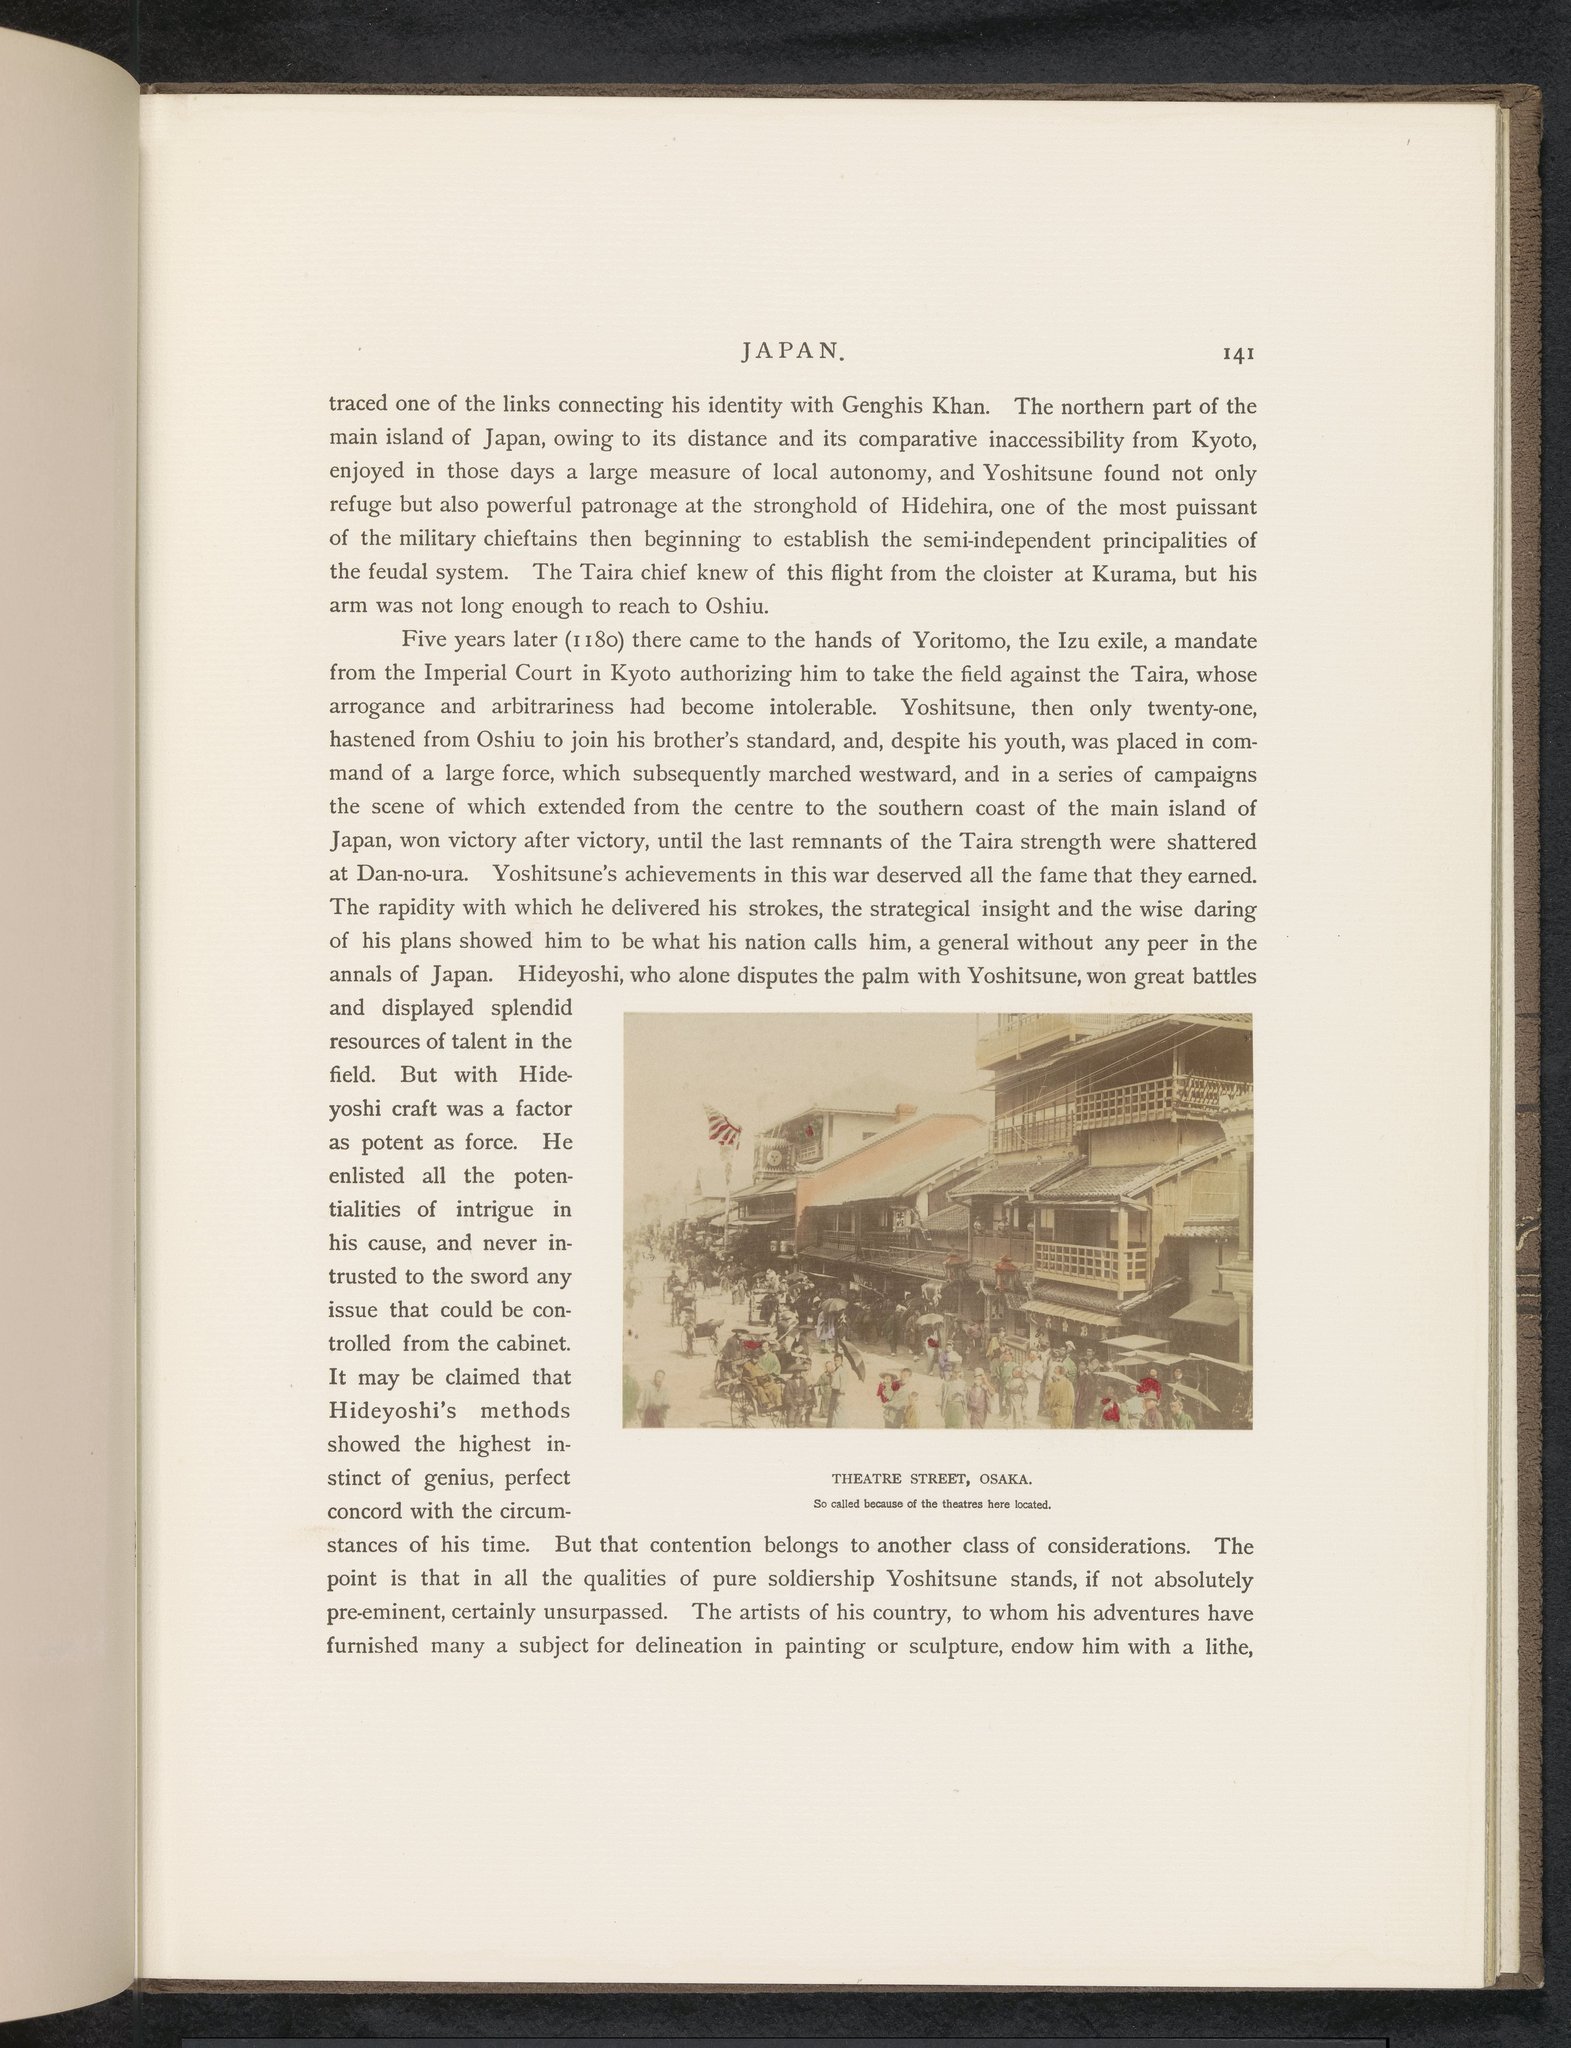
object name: photograph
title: Theatre street, Osaka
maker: Anonymous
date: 1887-1897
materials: photographic support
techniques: albumen print, hand coloring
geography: japan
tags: street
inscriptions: inscription: ‘So called because of the theatres here located.’